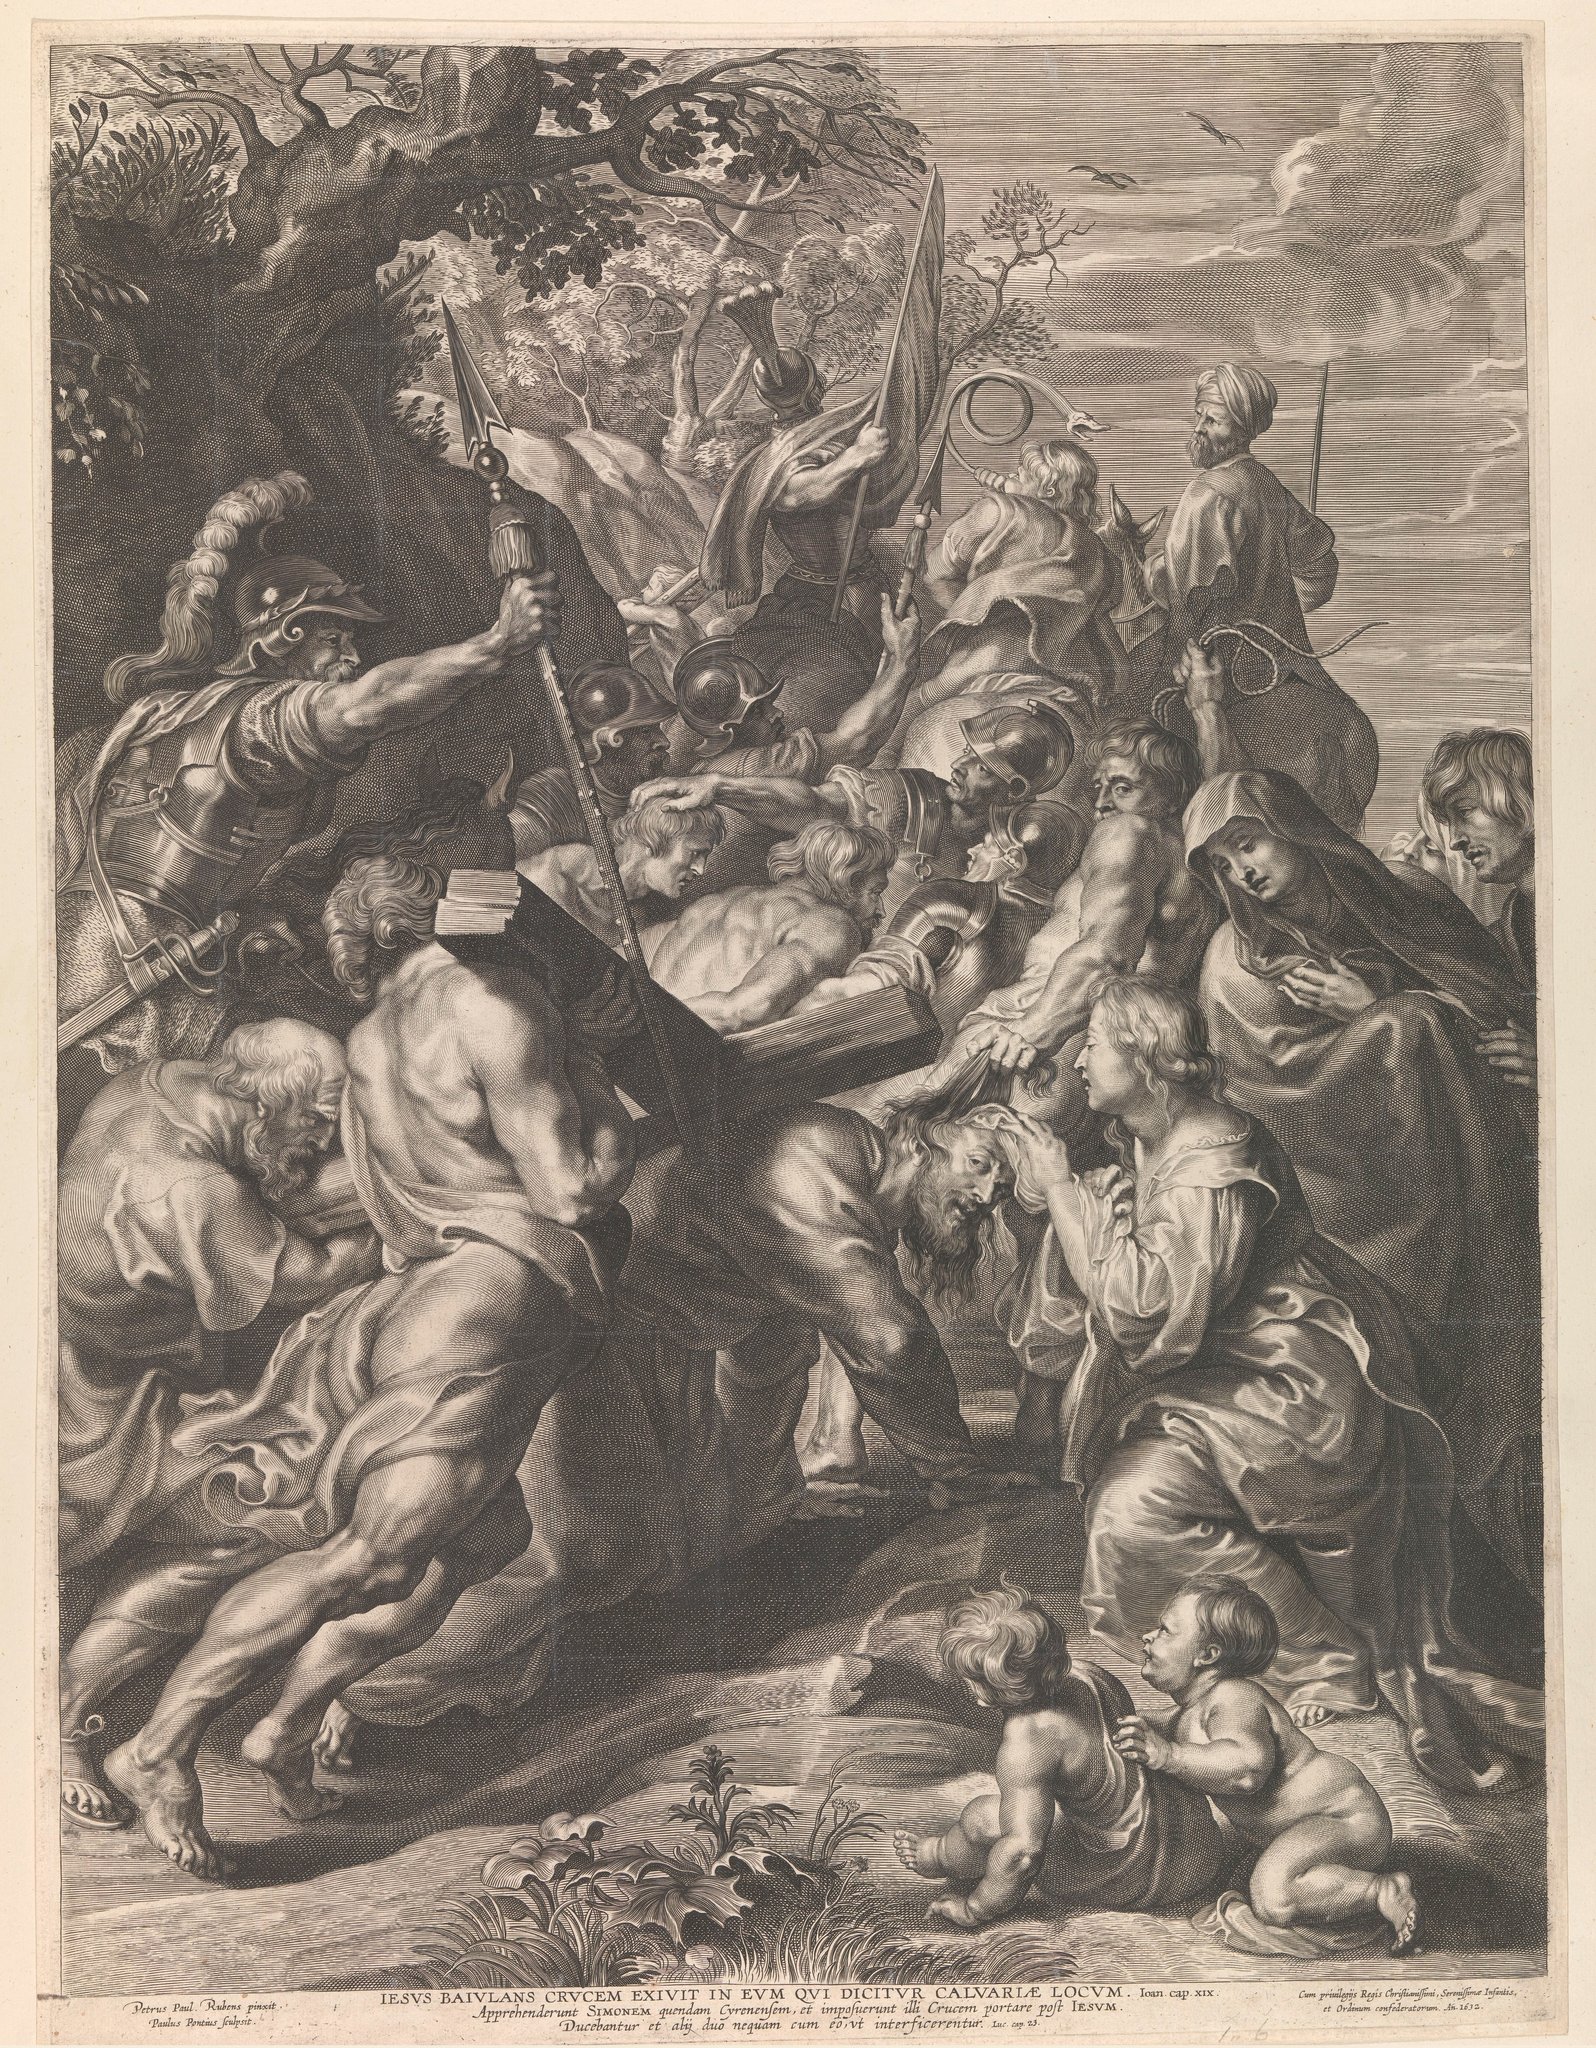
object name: album leaf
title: Kruisdraging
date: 1632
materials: paper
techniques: engraving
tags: carrying of the cross: christ bearing the cross, alone or with the help of others (e.g. simon the cyrenian)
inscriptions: date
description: Christus valt tijdens het dragen van zijn kruis naar Golgota. Een Romeinse soldaat spoort hem aan om op te staan. De twee misdadigers lopen voor hem. Veronica wist het zweet van zijn gezicht met een doek. Omstanders kijken bedroefd toe. Deze prent maakt deel uit van een album.